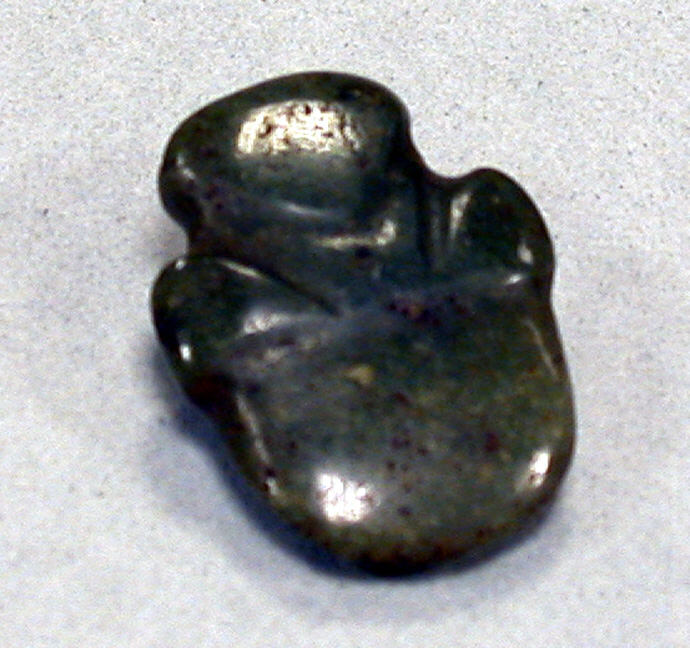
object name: pendant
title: Stone Pendant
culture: costa rican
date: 801-1500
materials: stone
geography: costa rica